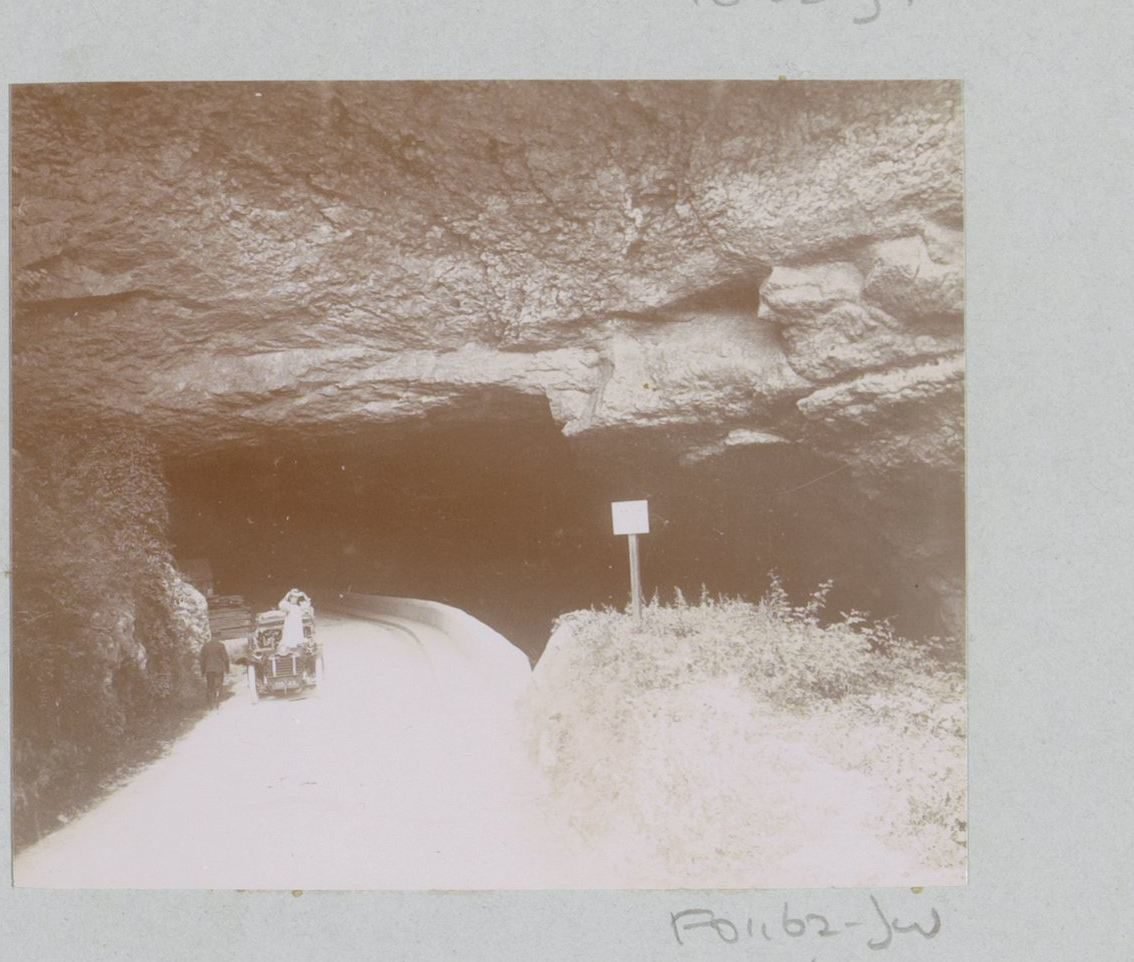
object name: photograph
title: Man en een vrouw bij een auto voor een rotstunnel, vermoedelijk in de Pyreneeën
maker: Anonymous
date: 1905-1910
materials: paper, photographic support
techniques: gelatin silver print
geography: pyrenees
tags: underground road, tunnel, automobile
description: Onderdeel van Fotoalbum van een Franse amateurfotograaf met bezienswaardigheden in Frankrijk, Zwitserland en Italië.